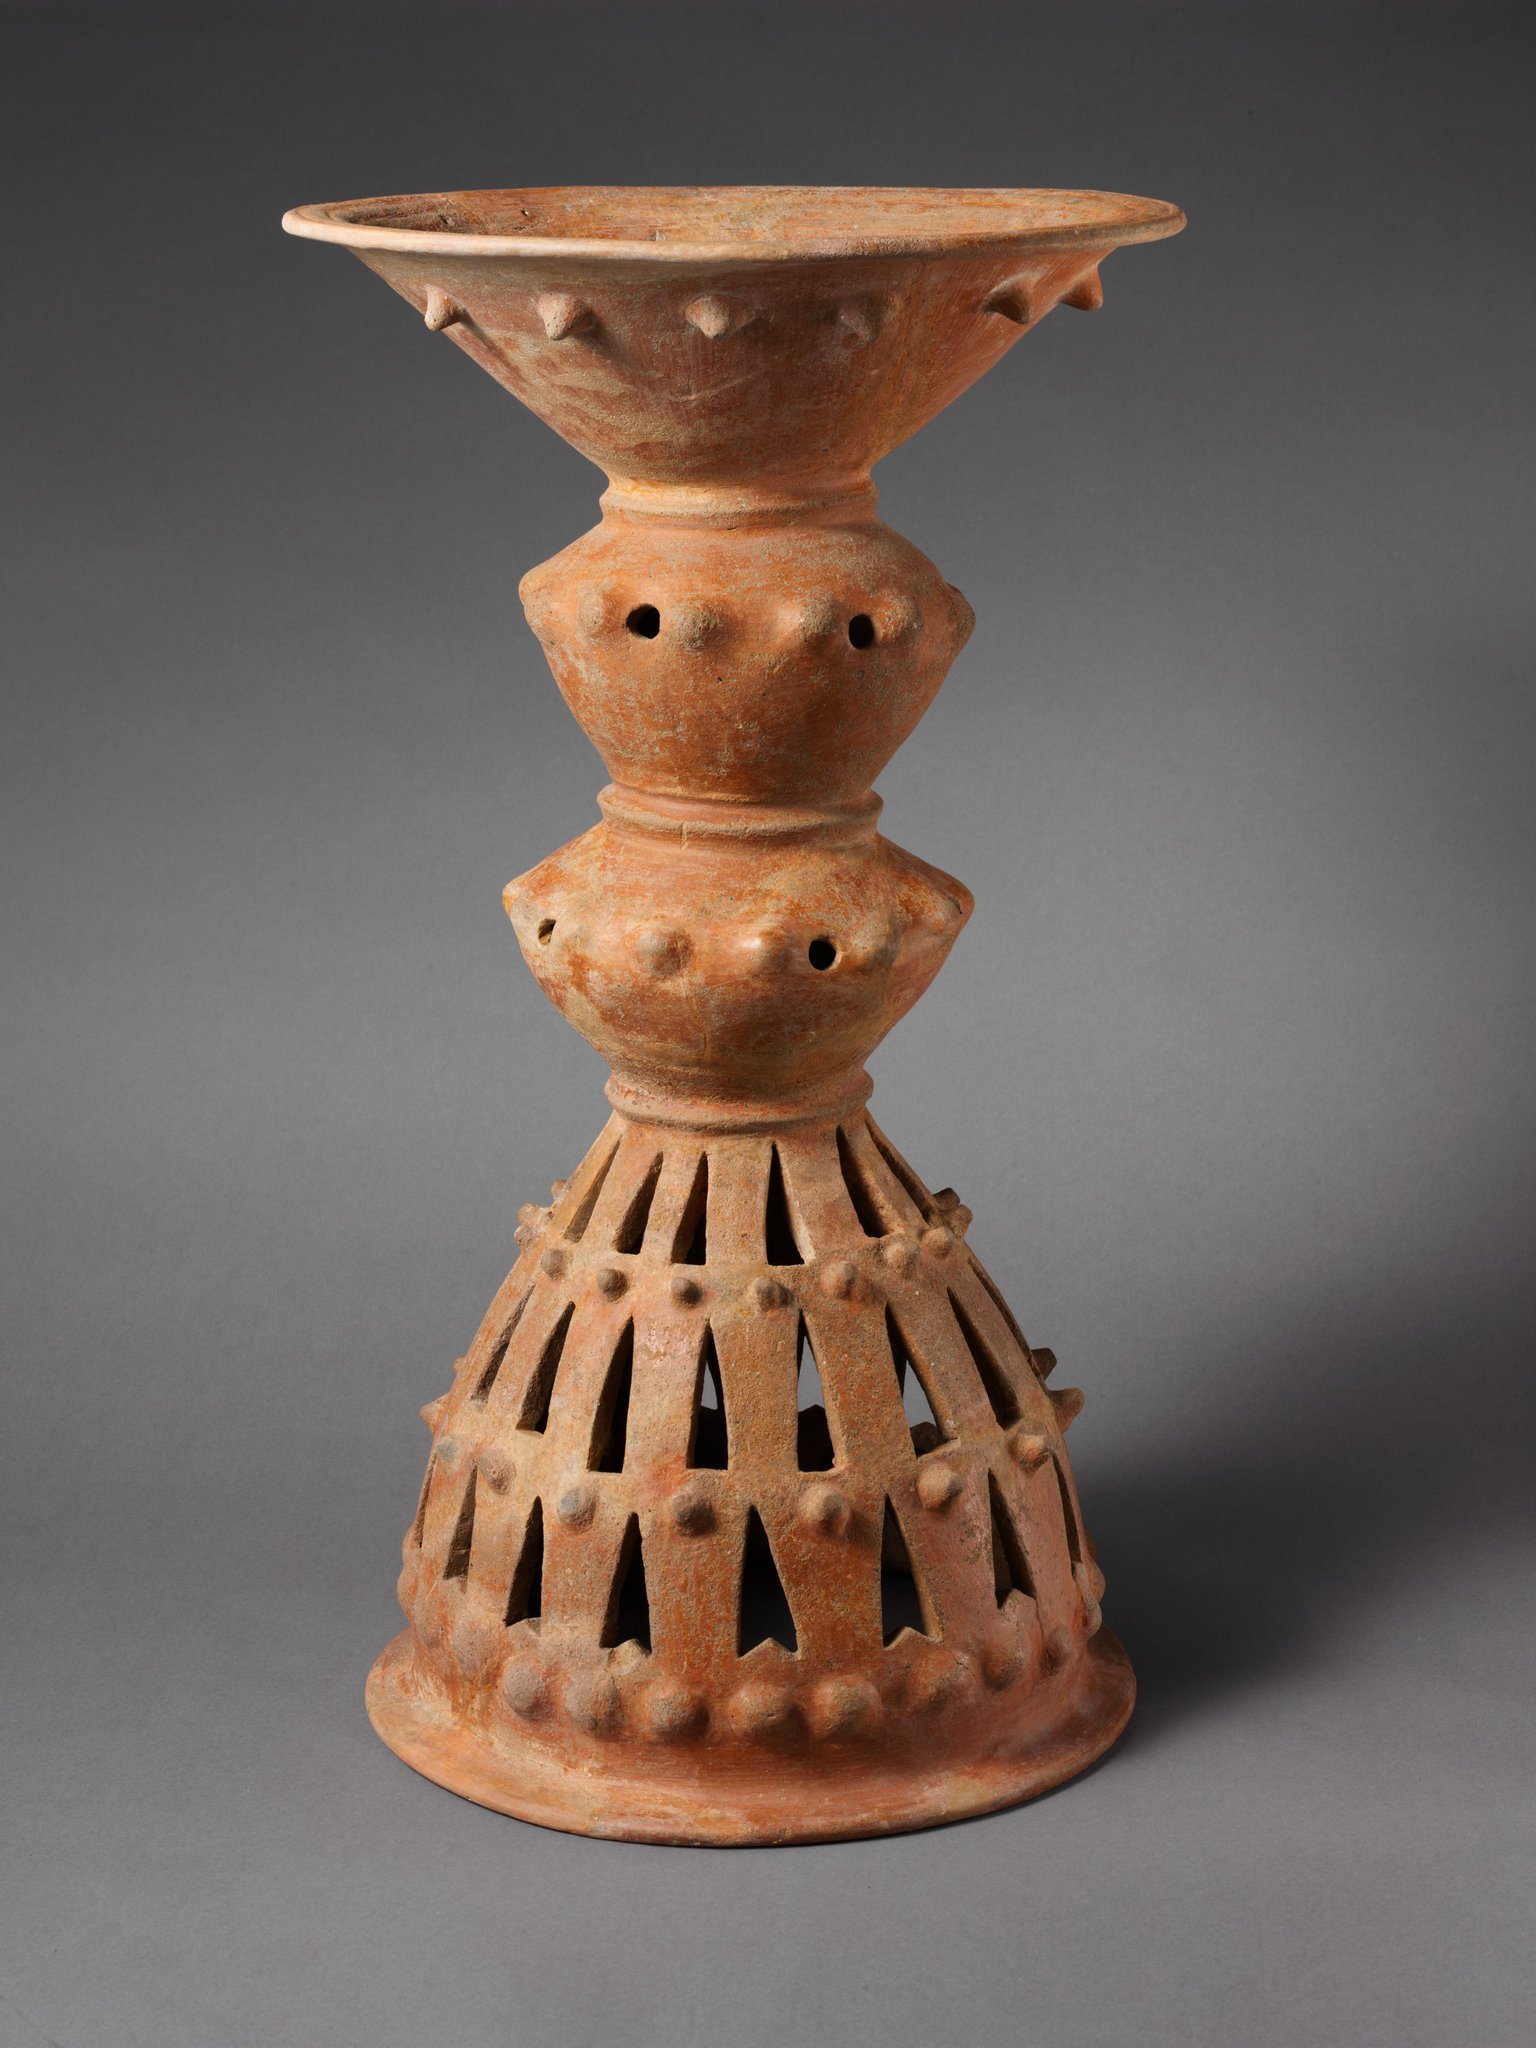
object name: stand, holmos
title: Terracotta holmos (stand)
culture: etruscan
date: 700-650 BCE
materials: terracotta